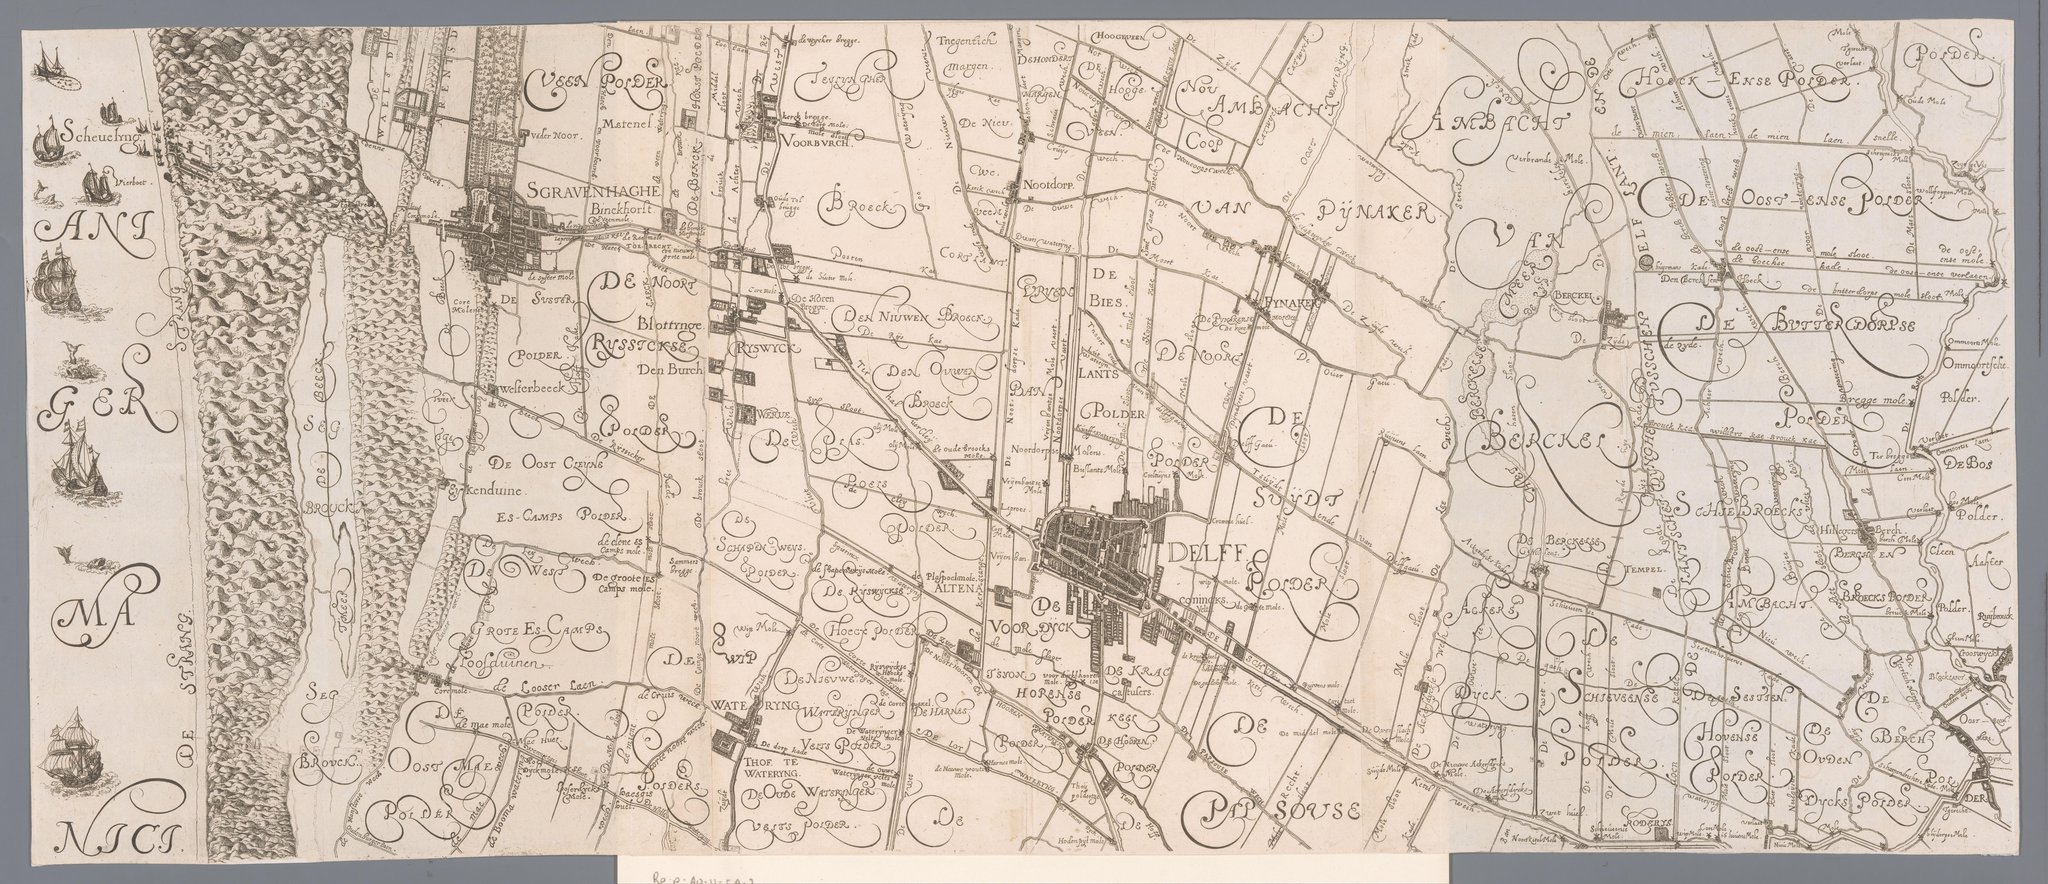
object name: map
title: Kaart van het Hoogheemraadschap van Delfland, met Den haag, Delft en Berkel en Rodenrijs, middelste deel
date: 1611-1692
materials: paper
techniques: engraving, etching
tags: maps of separate countries or regions, the hague, delft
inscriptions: collector's mark: Lugt 195